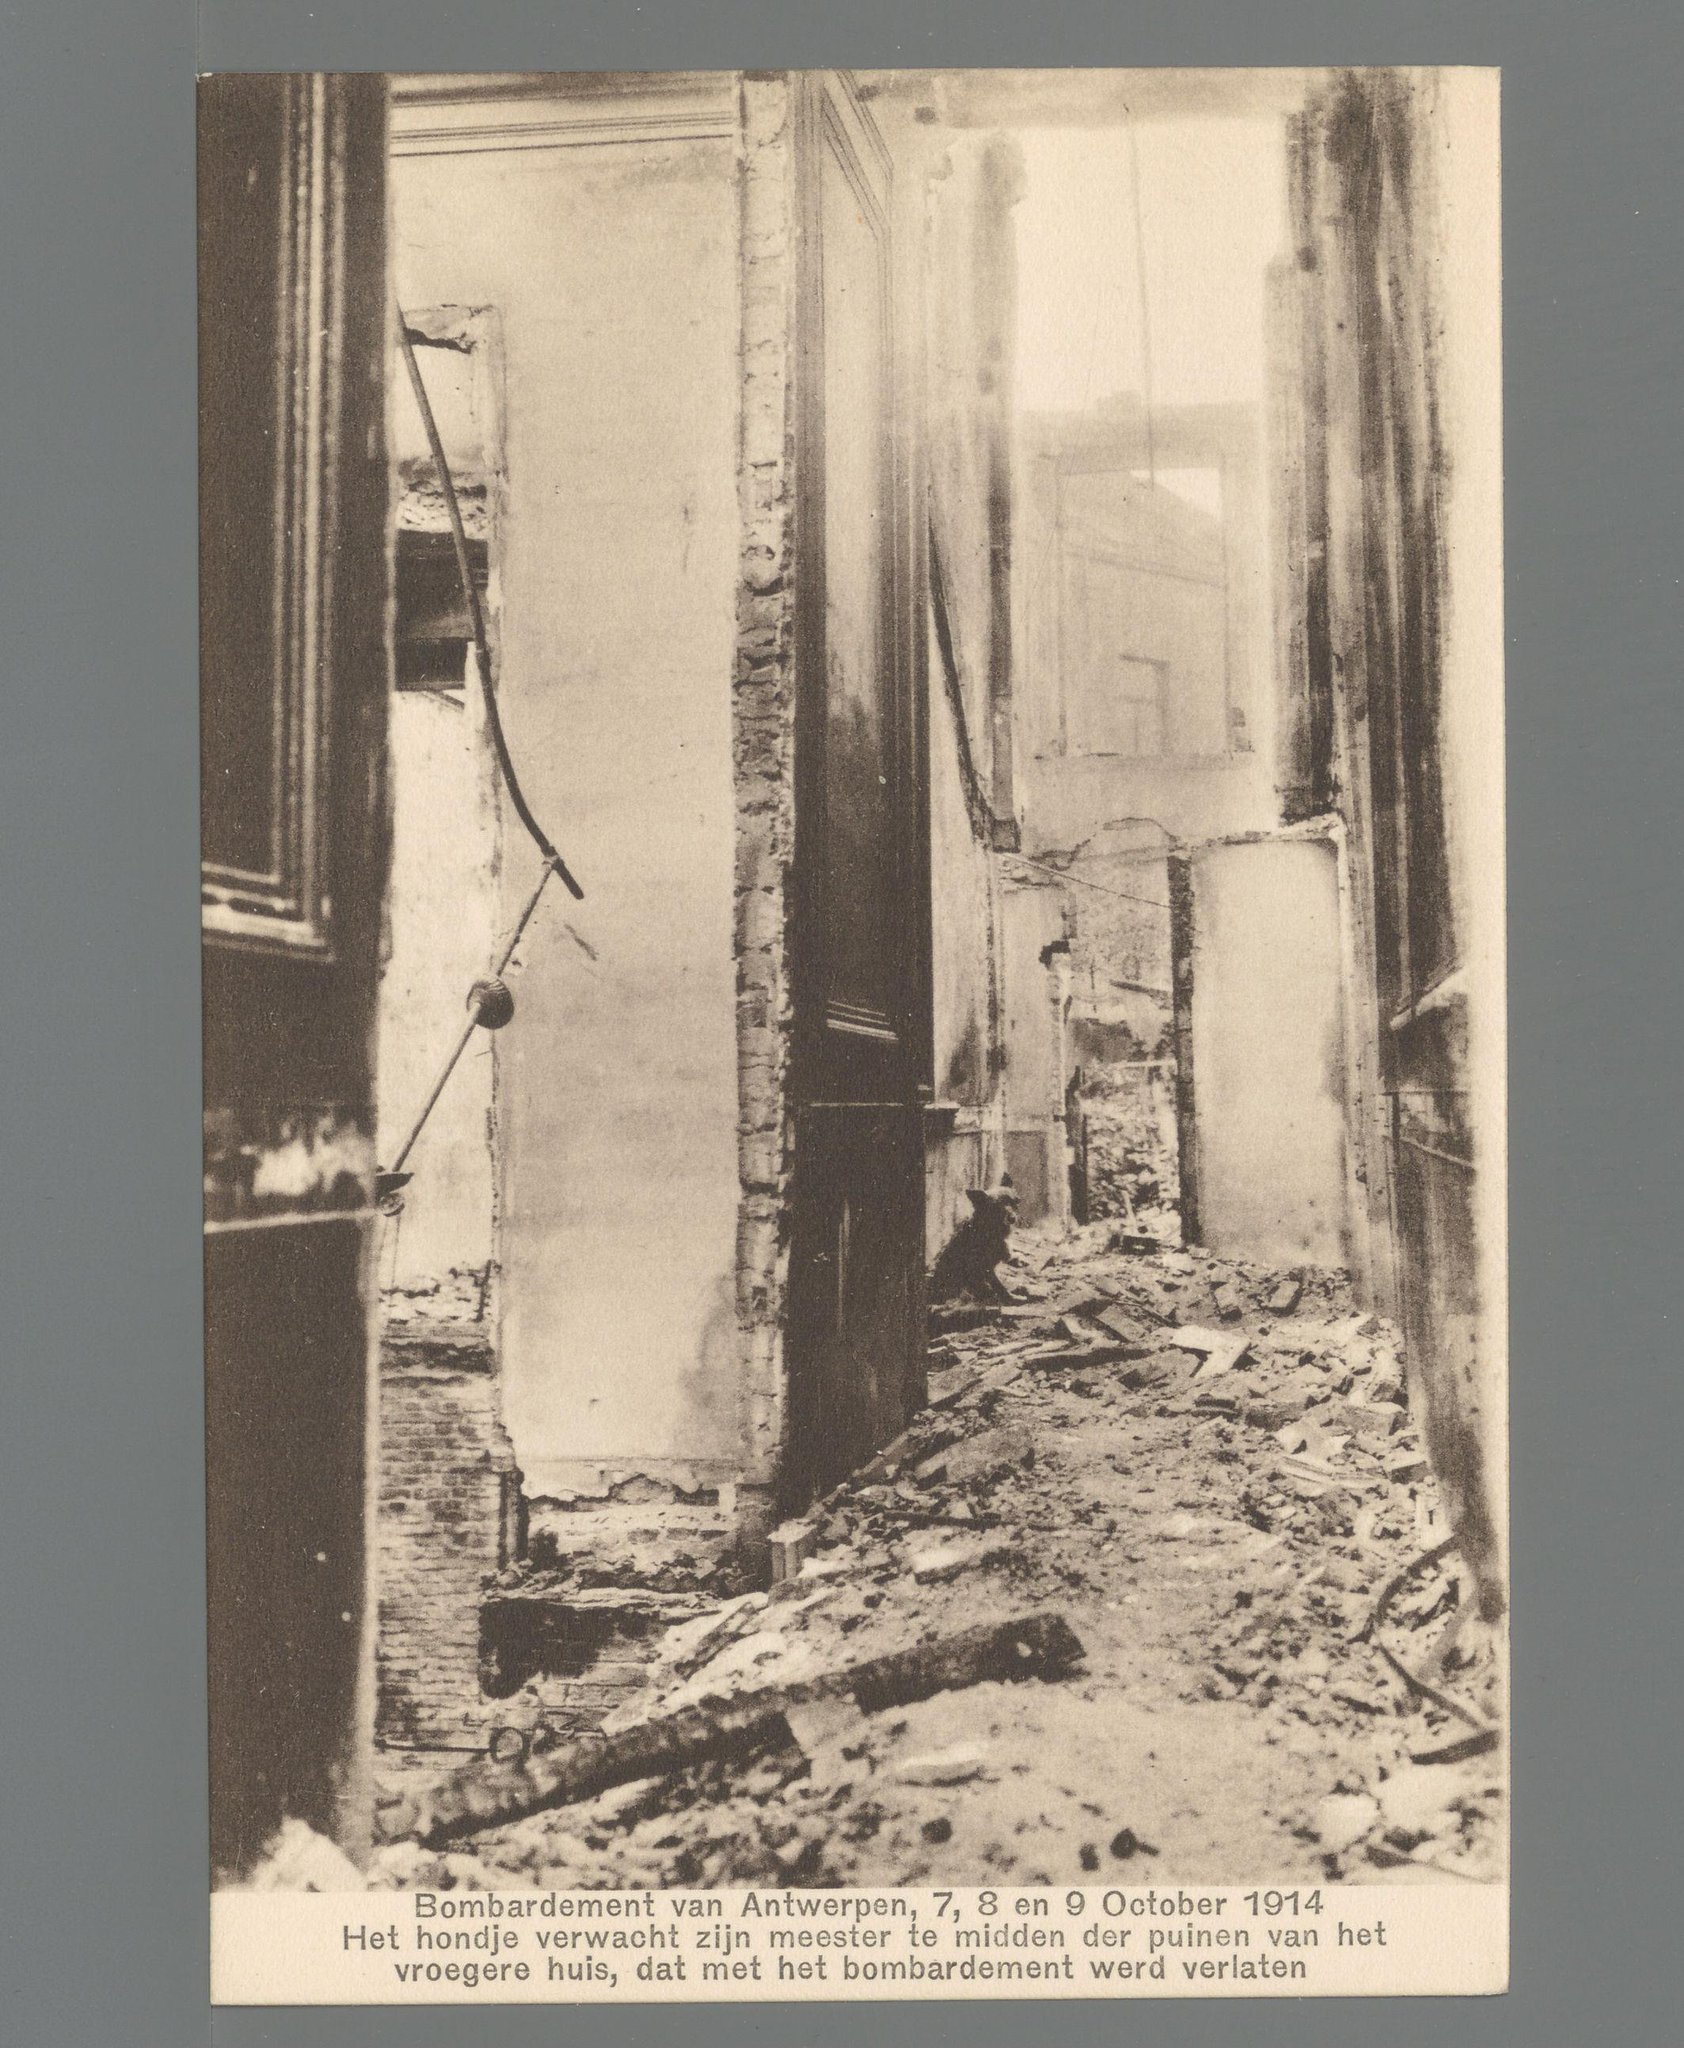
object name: photomechanical print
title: Bombardement van Antwerpen, 7, 8, en 9 October 1914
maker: Anonymous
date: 1914-1920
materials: cardboard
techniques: photograph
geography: rotterdam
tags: bombardment, demolishing (of conquered city), dog, antwerp